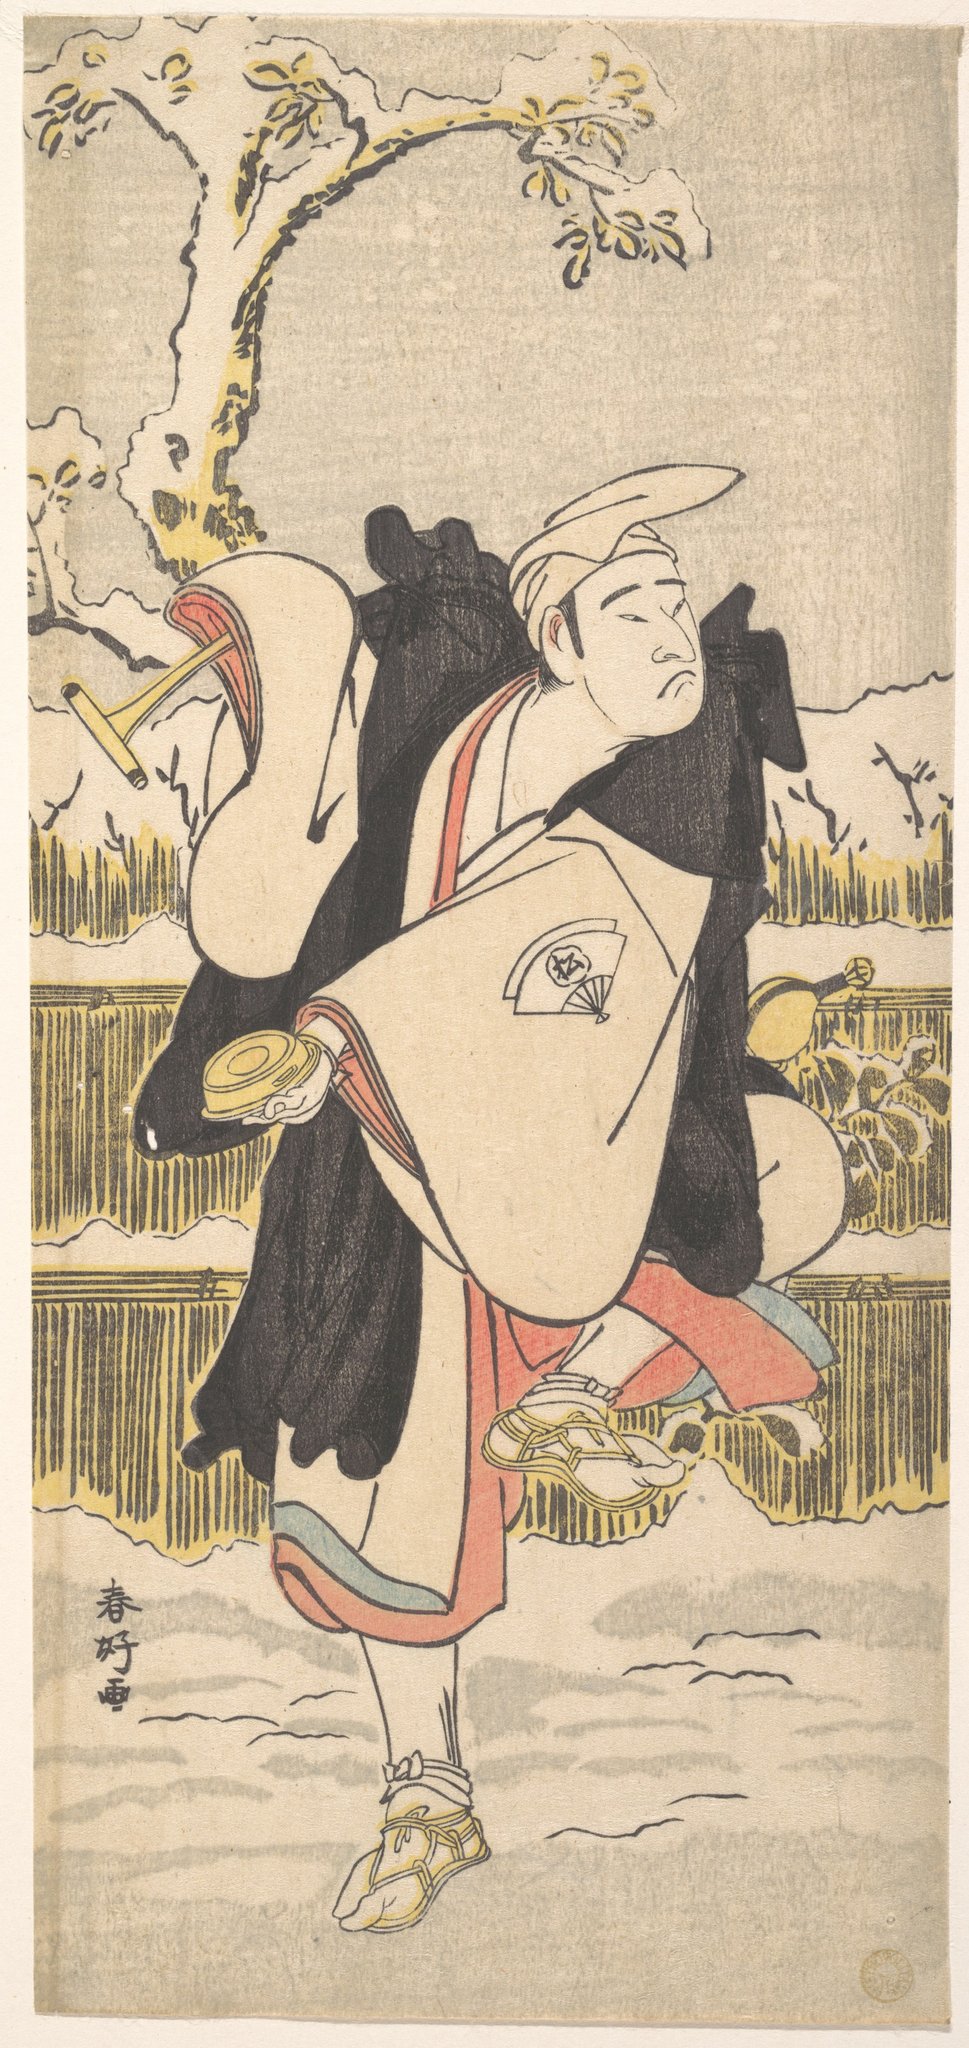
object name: print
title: Onoe Matsusuke as a Kannen-Butsu or Mendicant Buddhist Monk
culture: japanese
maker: katsukawa shunkō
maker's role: artist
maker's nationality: japanese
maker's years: 1743-1812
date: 1790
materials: ink, paper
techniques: woodblock print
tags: men,trees,actors